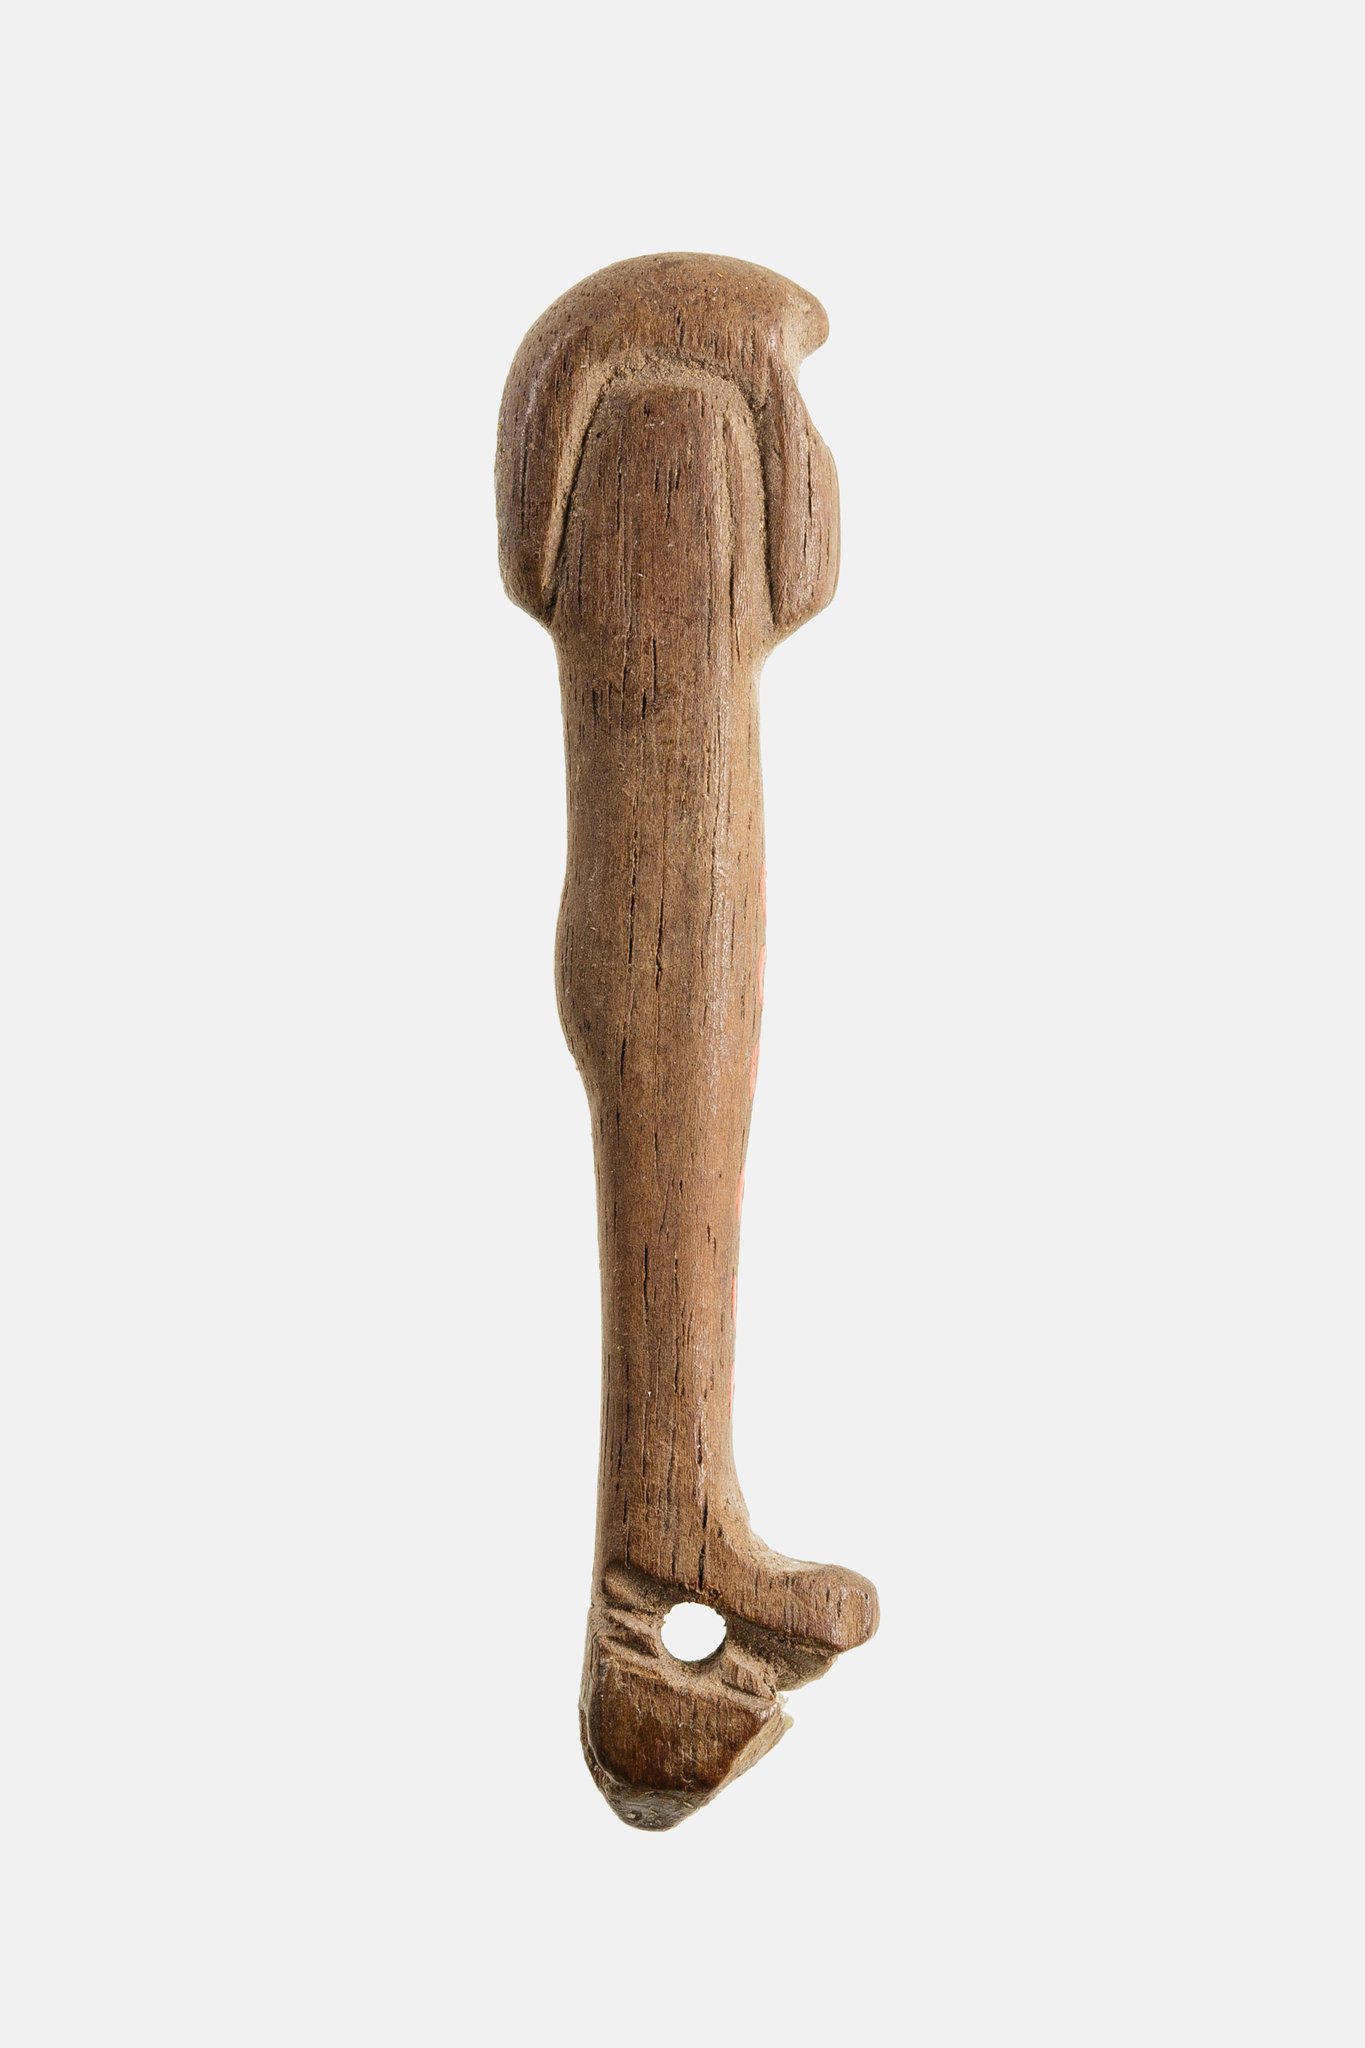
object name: amulet, son of horus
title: Mummiform Horus Figure amulet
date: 1070-343 BCE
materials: wood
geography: egypt